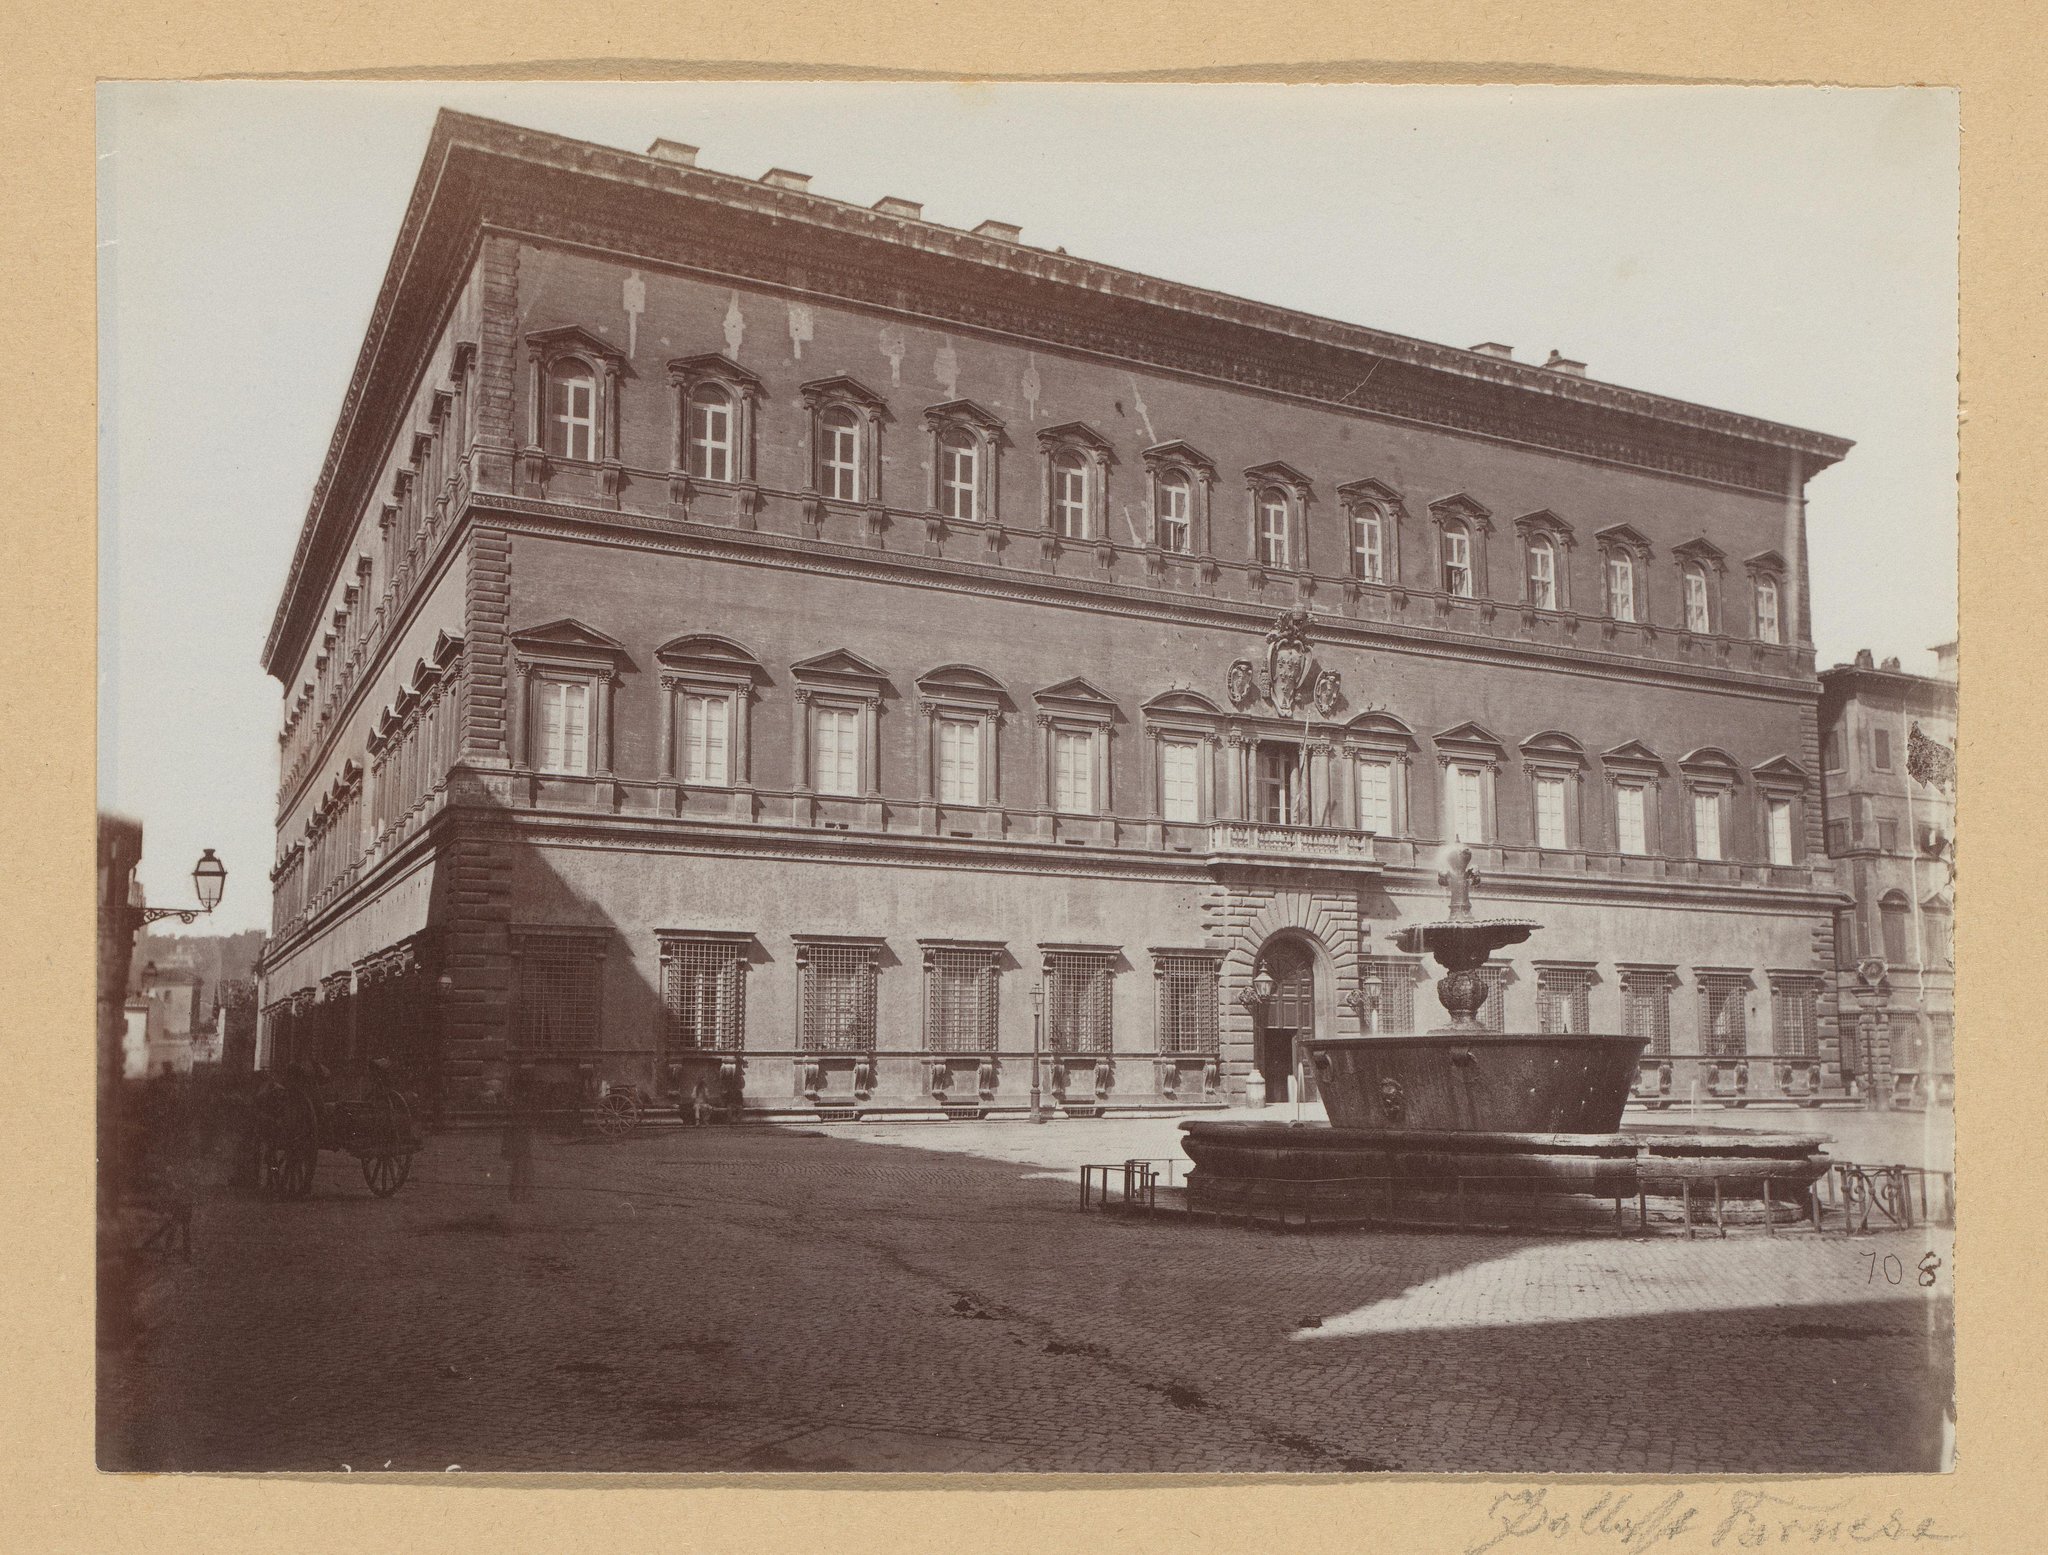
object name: photograph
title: Rome, Palazzo Farnese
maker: Anonymous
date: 1860-1890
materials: photographic support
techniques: albumen print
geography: rome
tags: palace, façade (of house or building)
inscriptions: number: ‘708’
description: Onderdeel van Reisalbum met opnames van kunstwerken en bezienswaardigheden in Italië, Griekenland en Frankrijk.